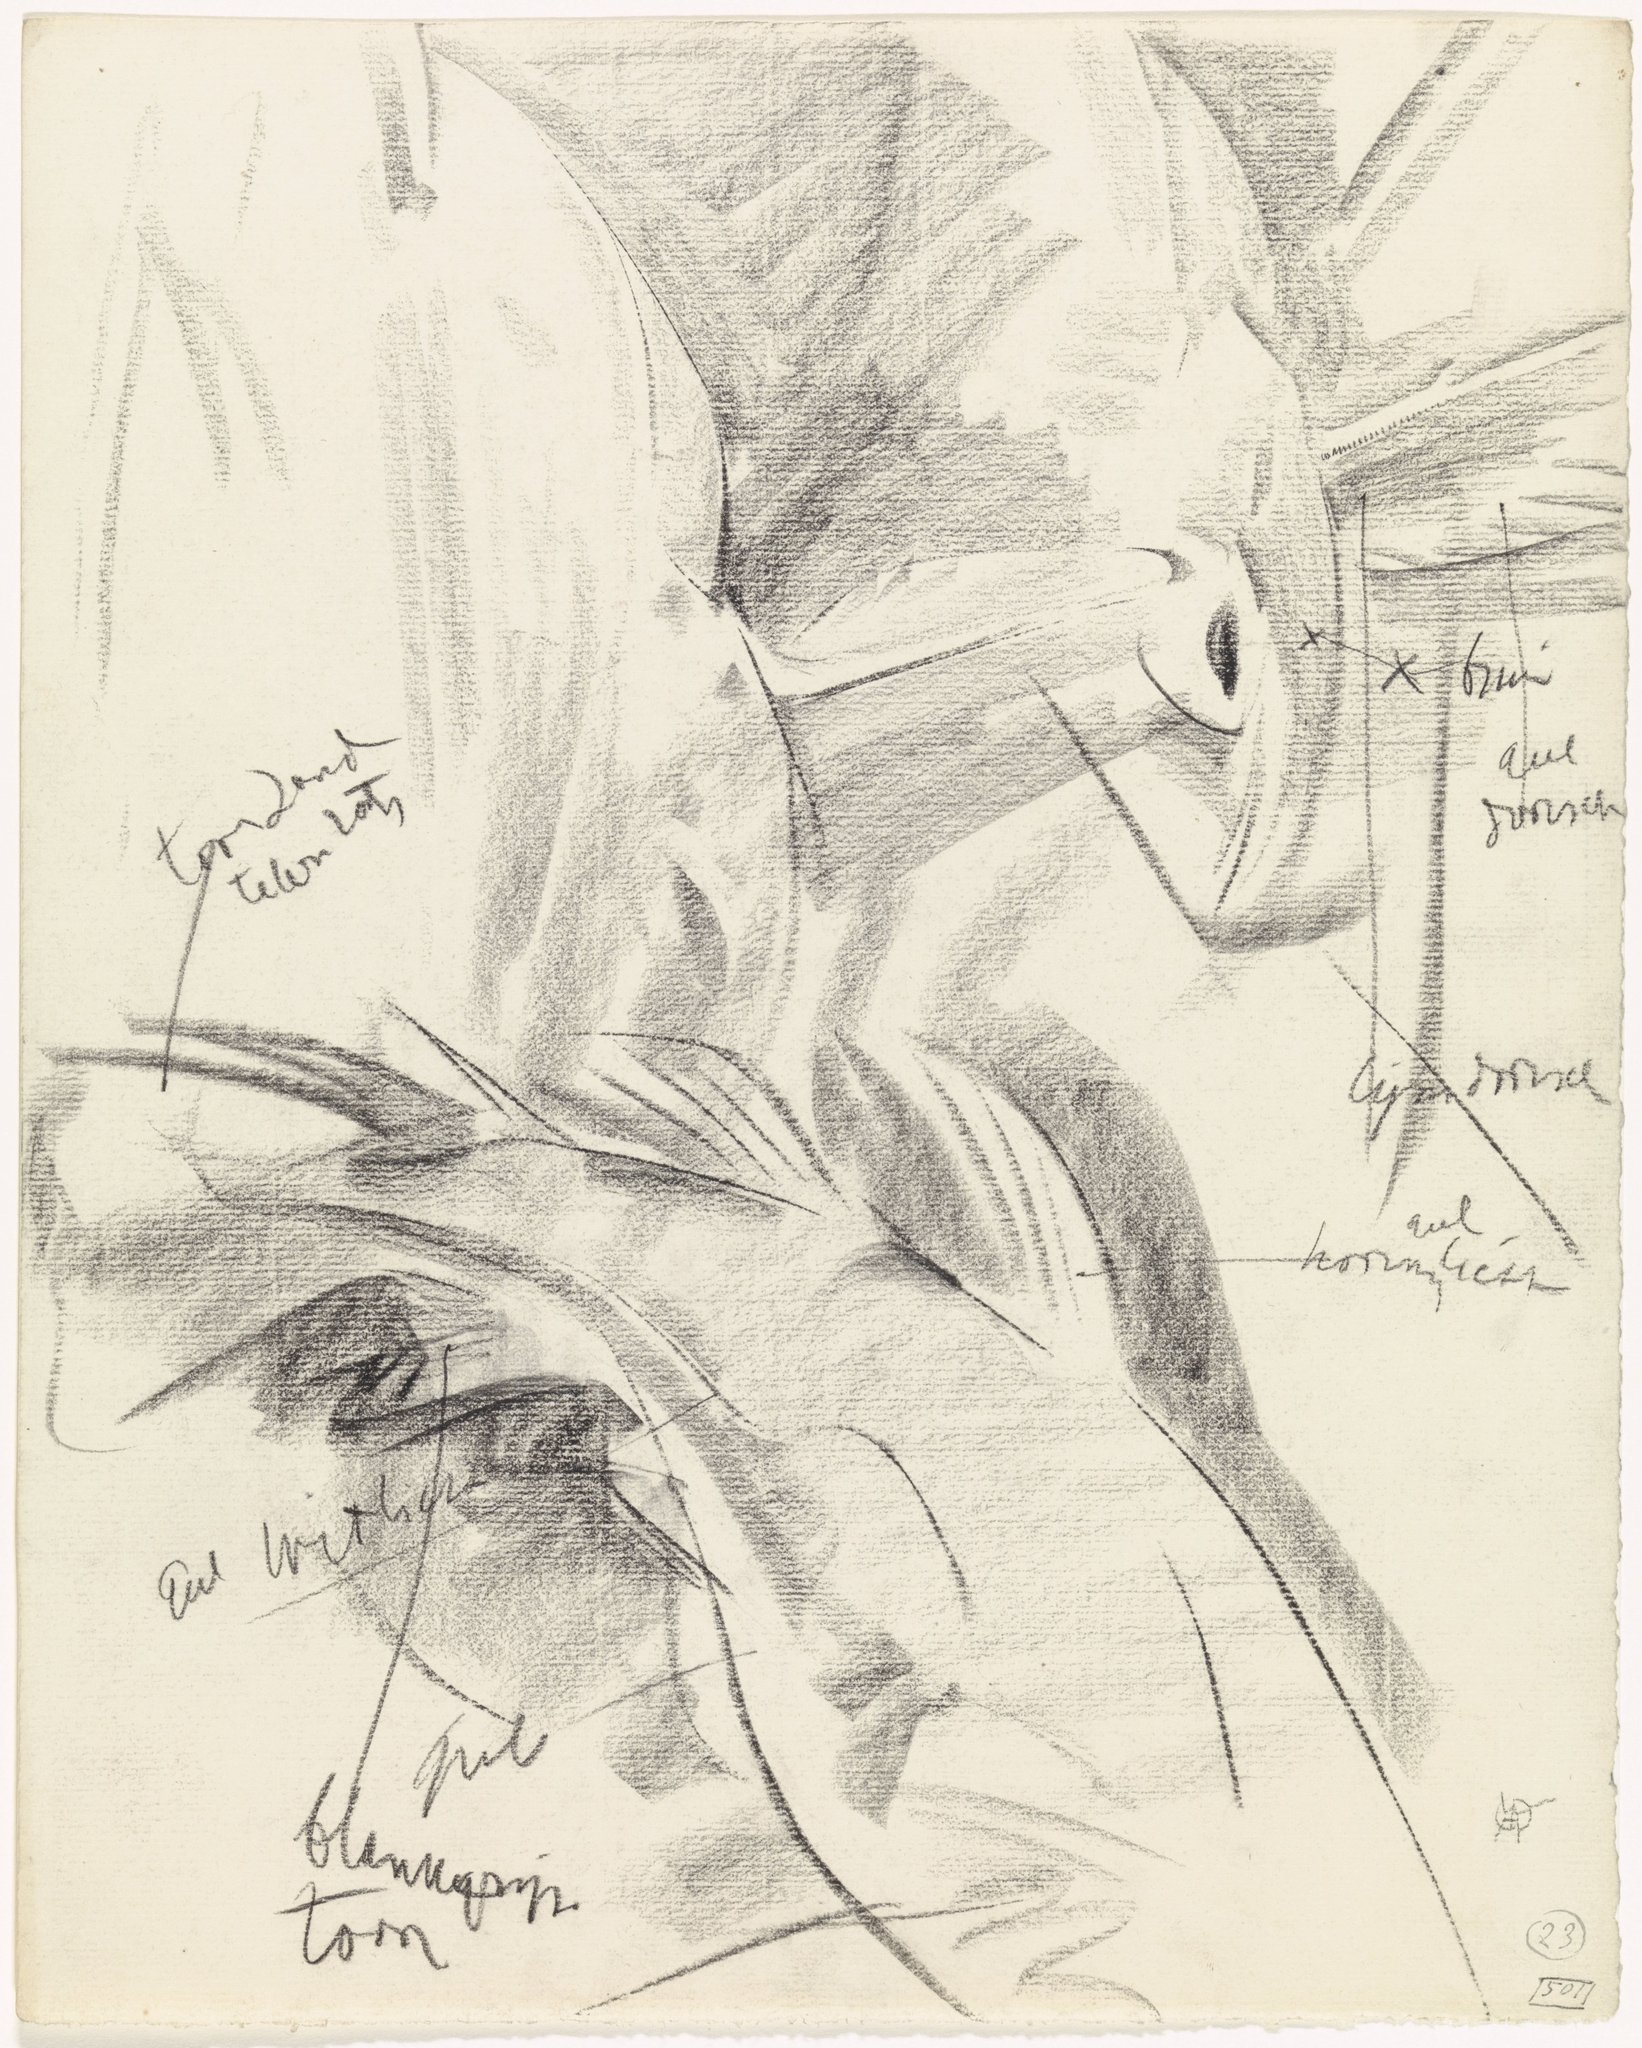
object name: drawing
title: Studies van een vis, met kleurnotities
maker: gerrit willem dijsselhof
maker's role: designer, draughtsman, print maker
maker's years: 1866-1924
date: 1876-1924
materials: chalk, paper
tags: bony fishes